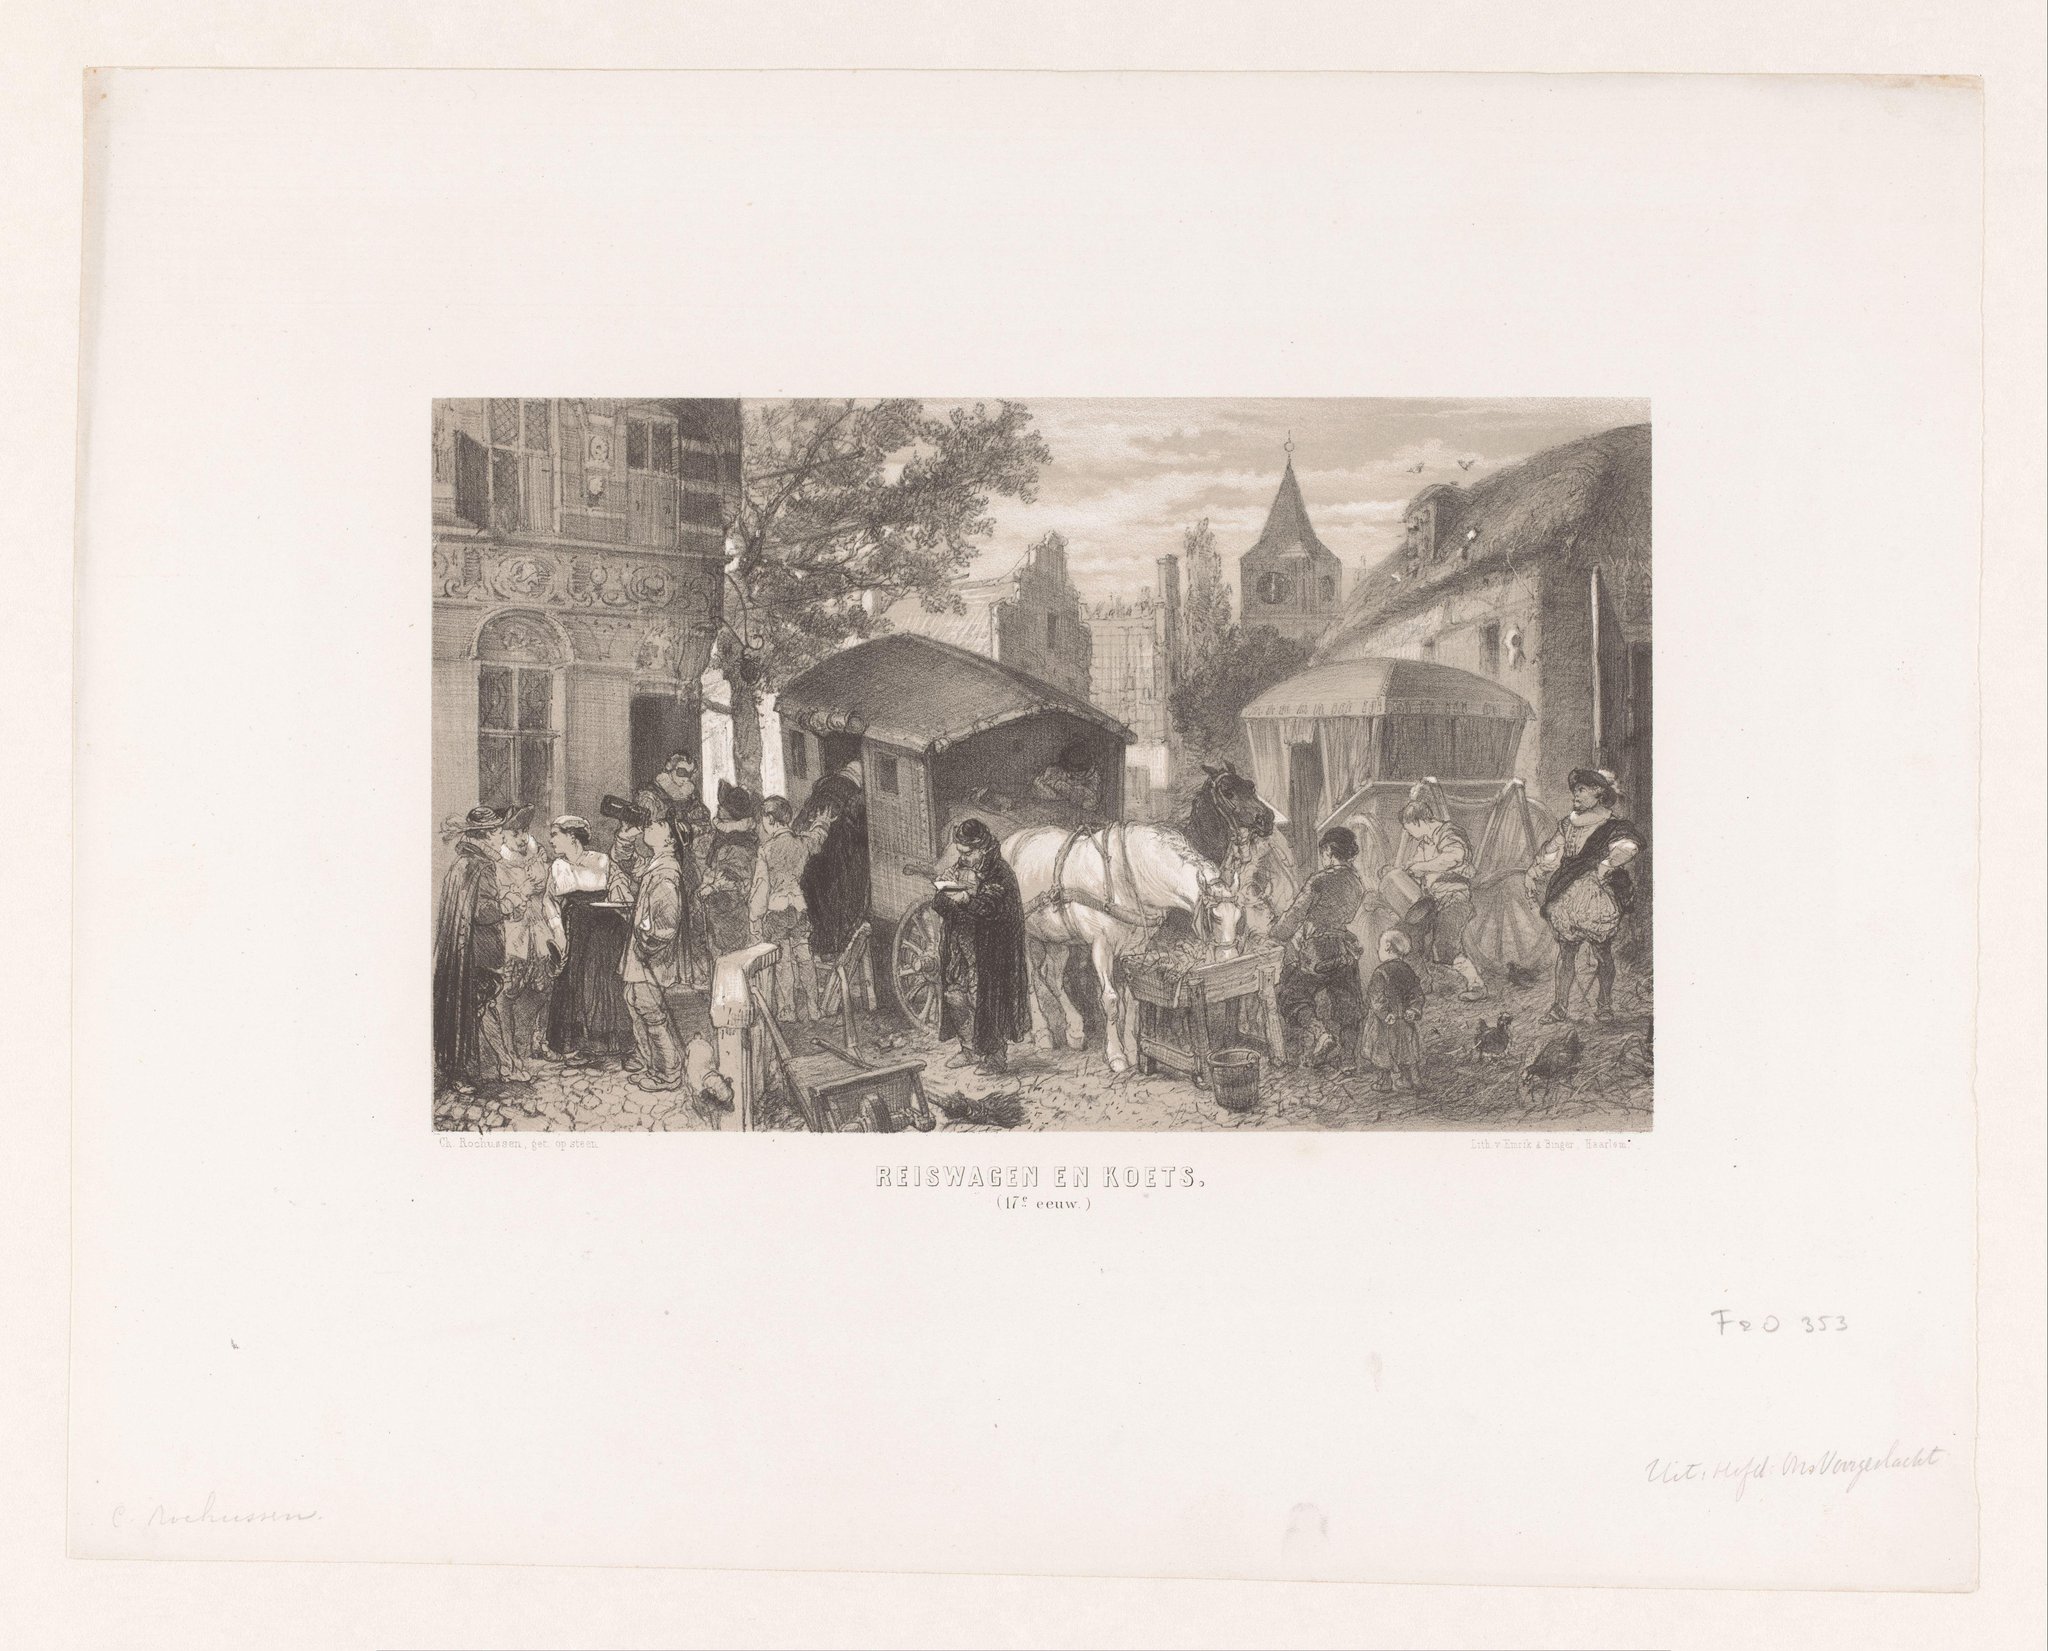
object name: book illustration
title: Reiswagen en koets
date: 1858-1864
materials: paper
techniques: tone lithography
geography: haarlem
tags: four-wheeled, animal-drawn vehicle, e.g.: cab, carriage, coach, travelling; tourism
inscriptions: collector's mark: Lugt 2228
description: Prent uit: Hofdijk, W.F. Ons voorgeslacht in zijn dagelijksch leven geschilderd. Haarlem: Kruseman, Arie Cornelis, 1858-1864.